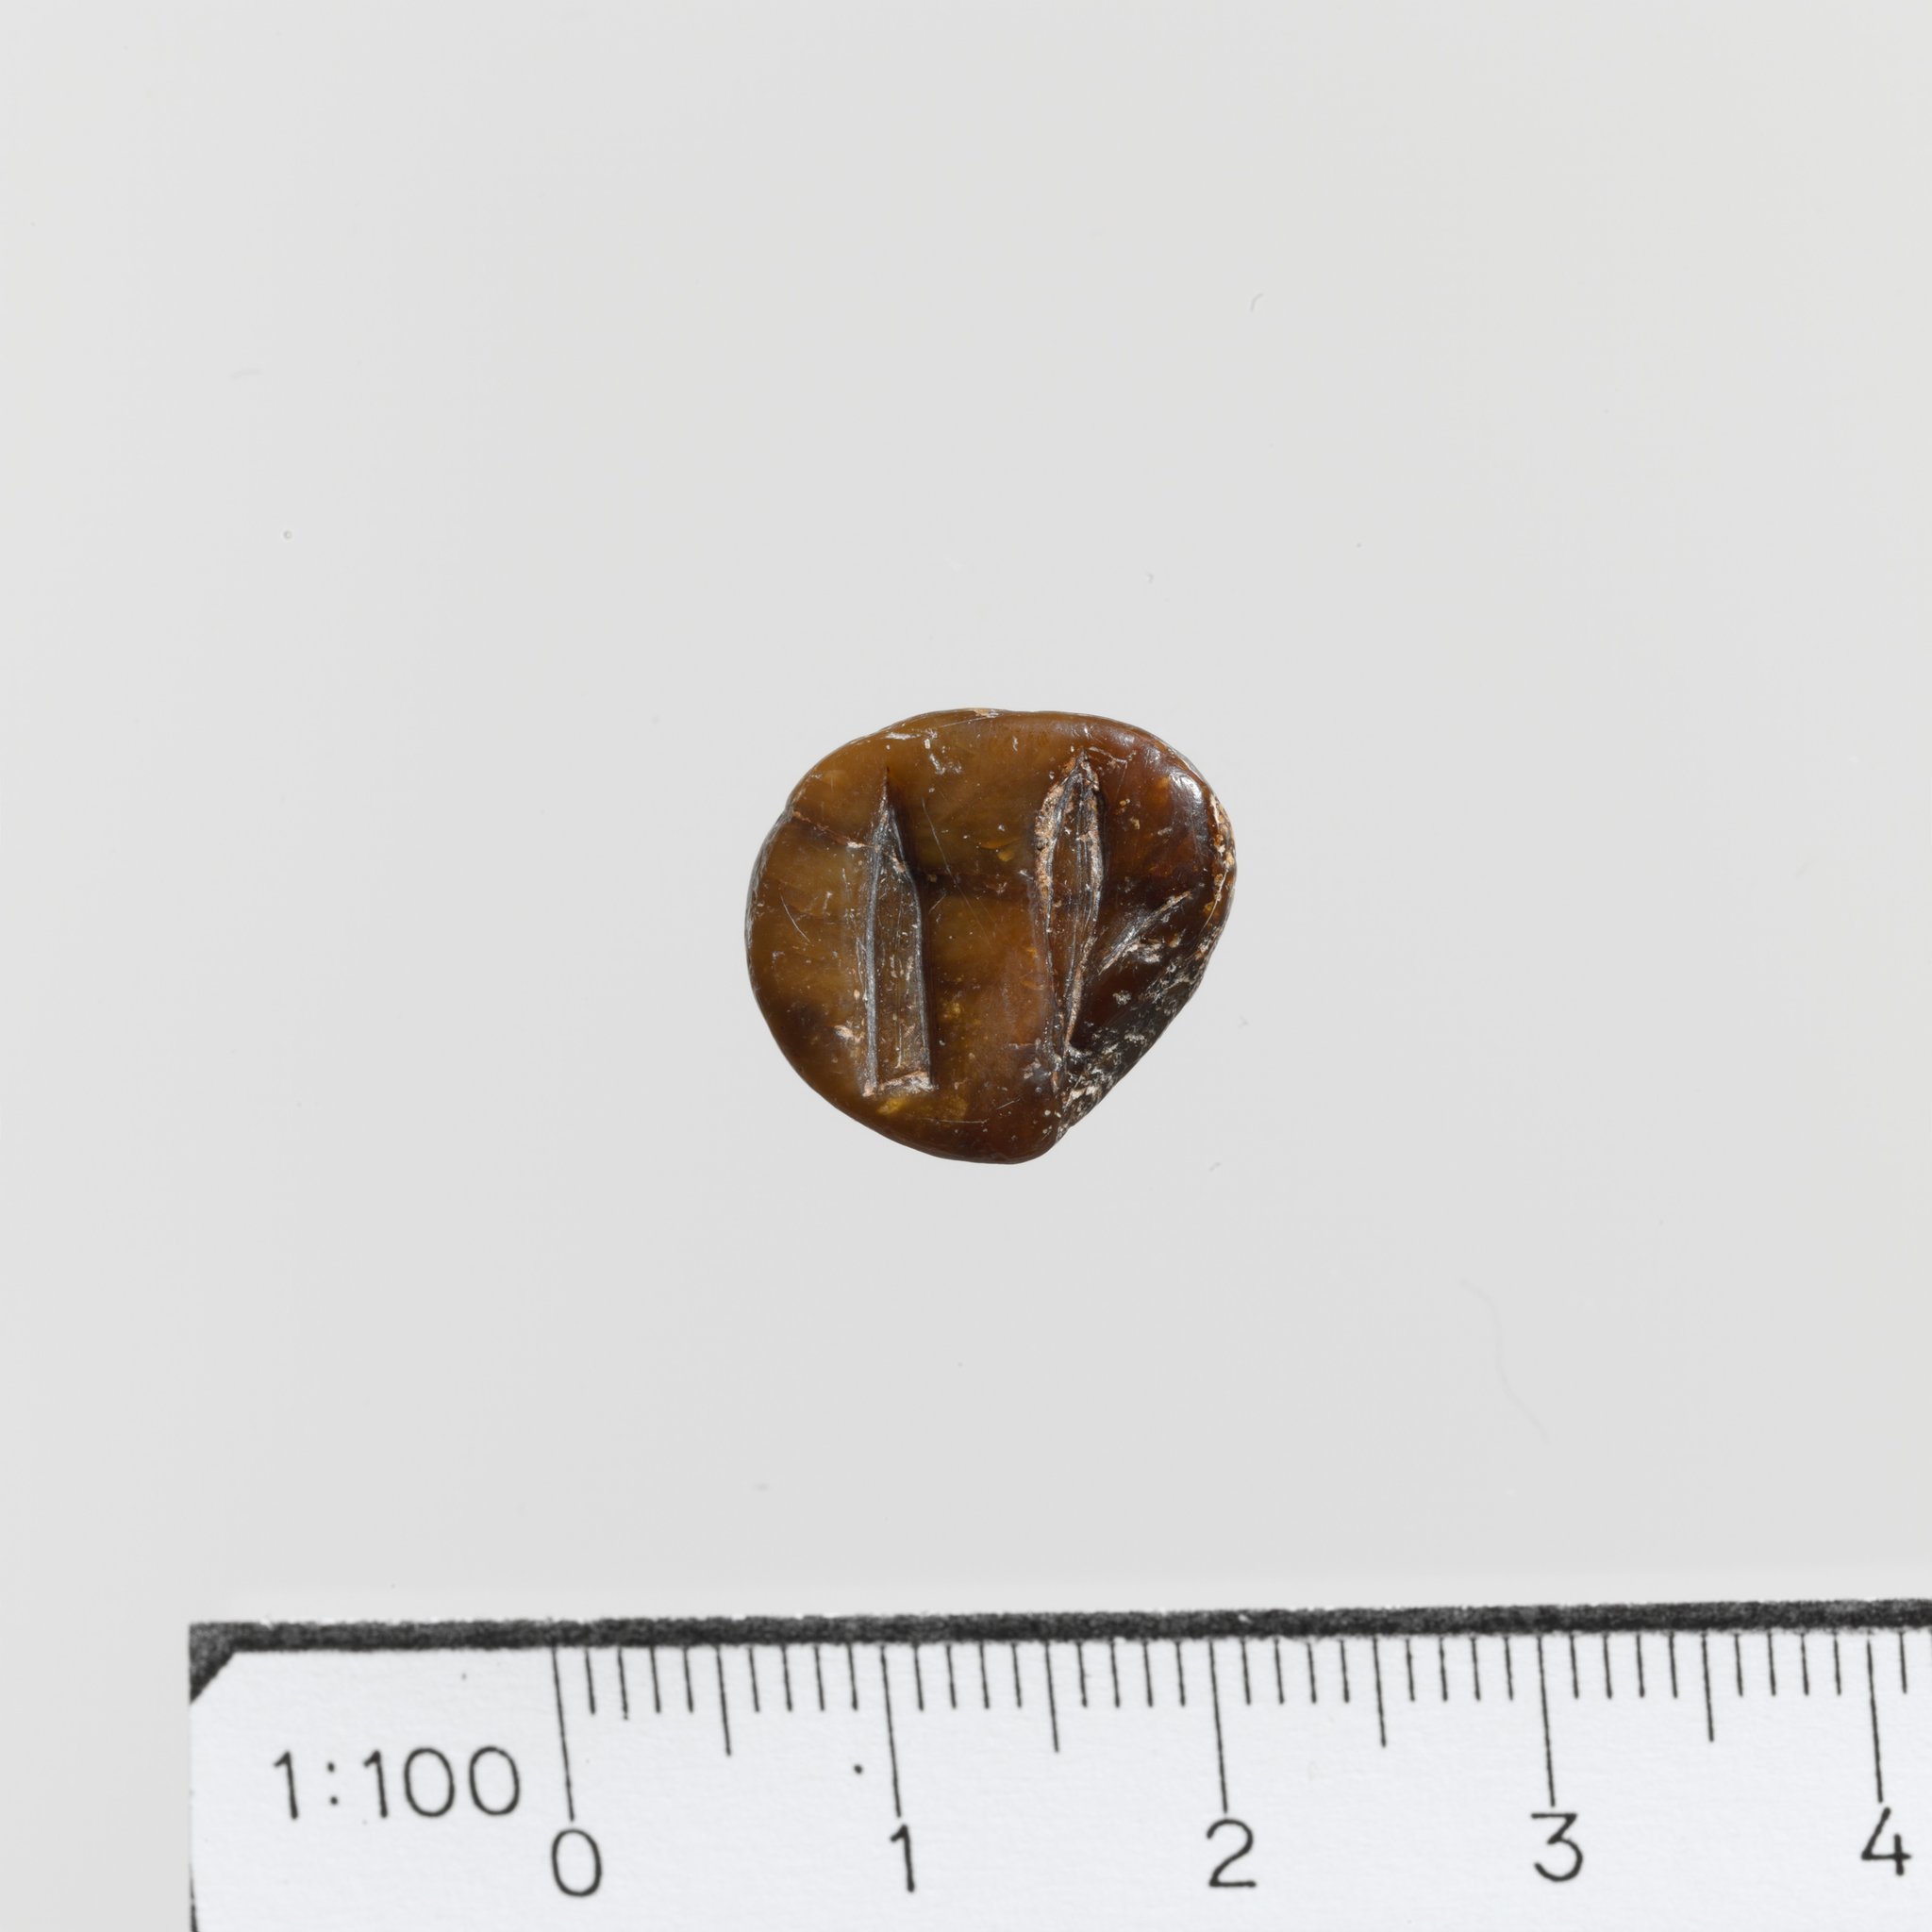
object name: stamp seal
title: Seal Stamp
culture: minoan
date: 1800-1700 BCE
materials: stone